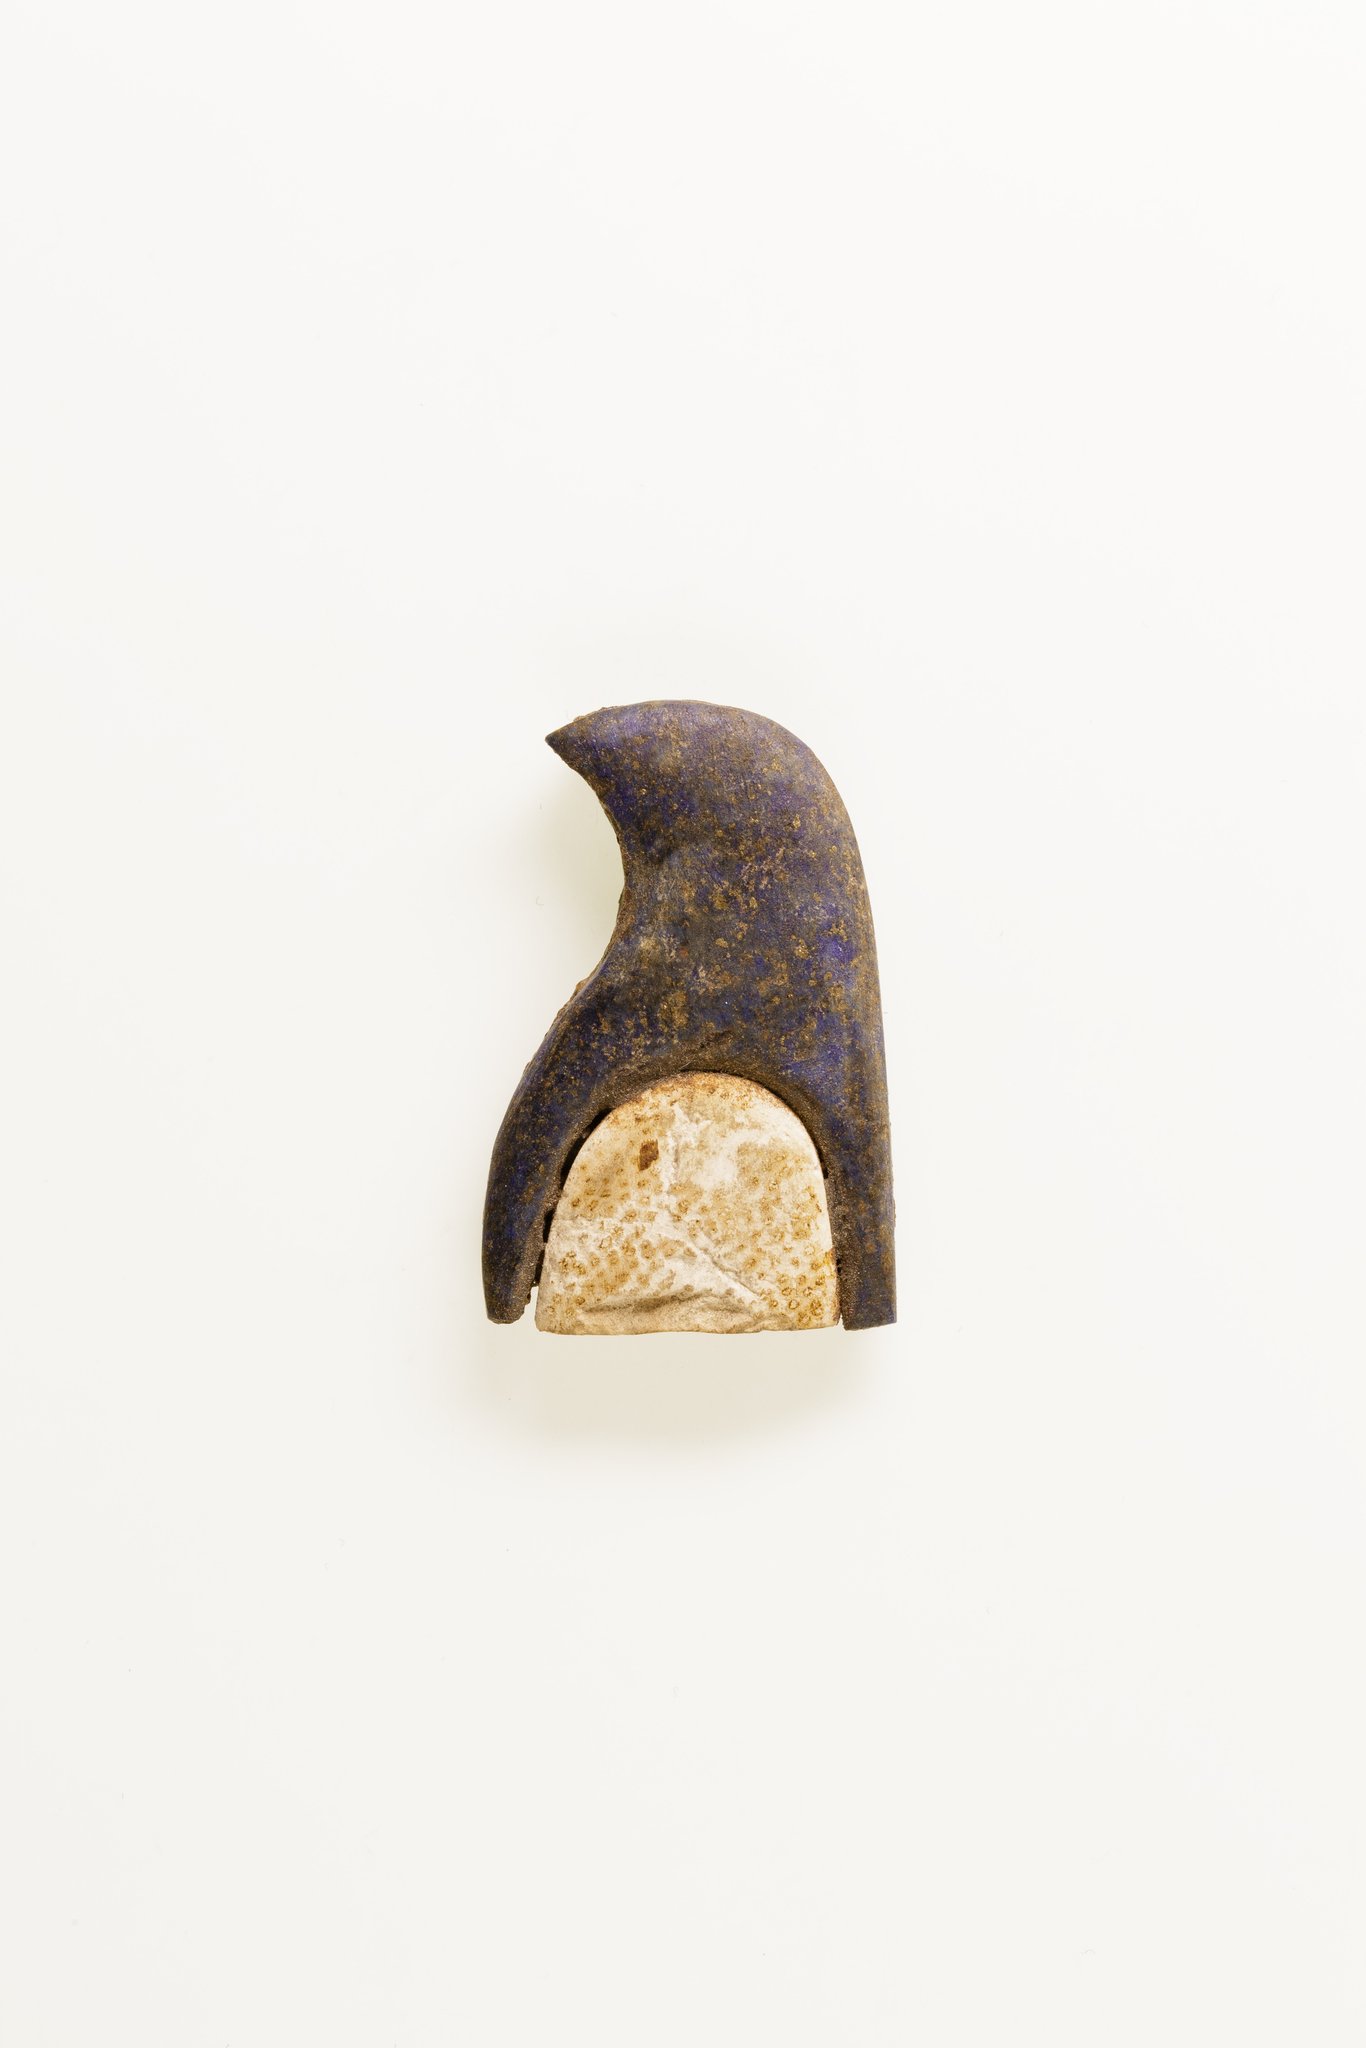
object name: inlay, wig and shoulder of figure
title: Wig inlay and shoulder of figure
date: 522-343 BCE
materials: ivory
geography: egypt